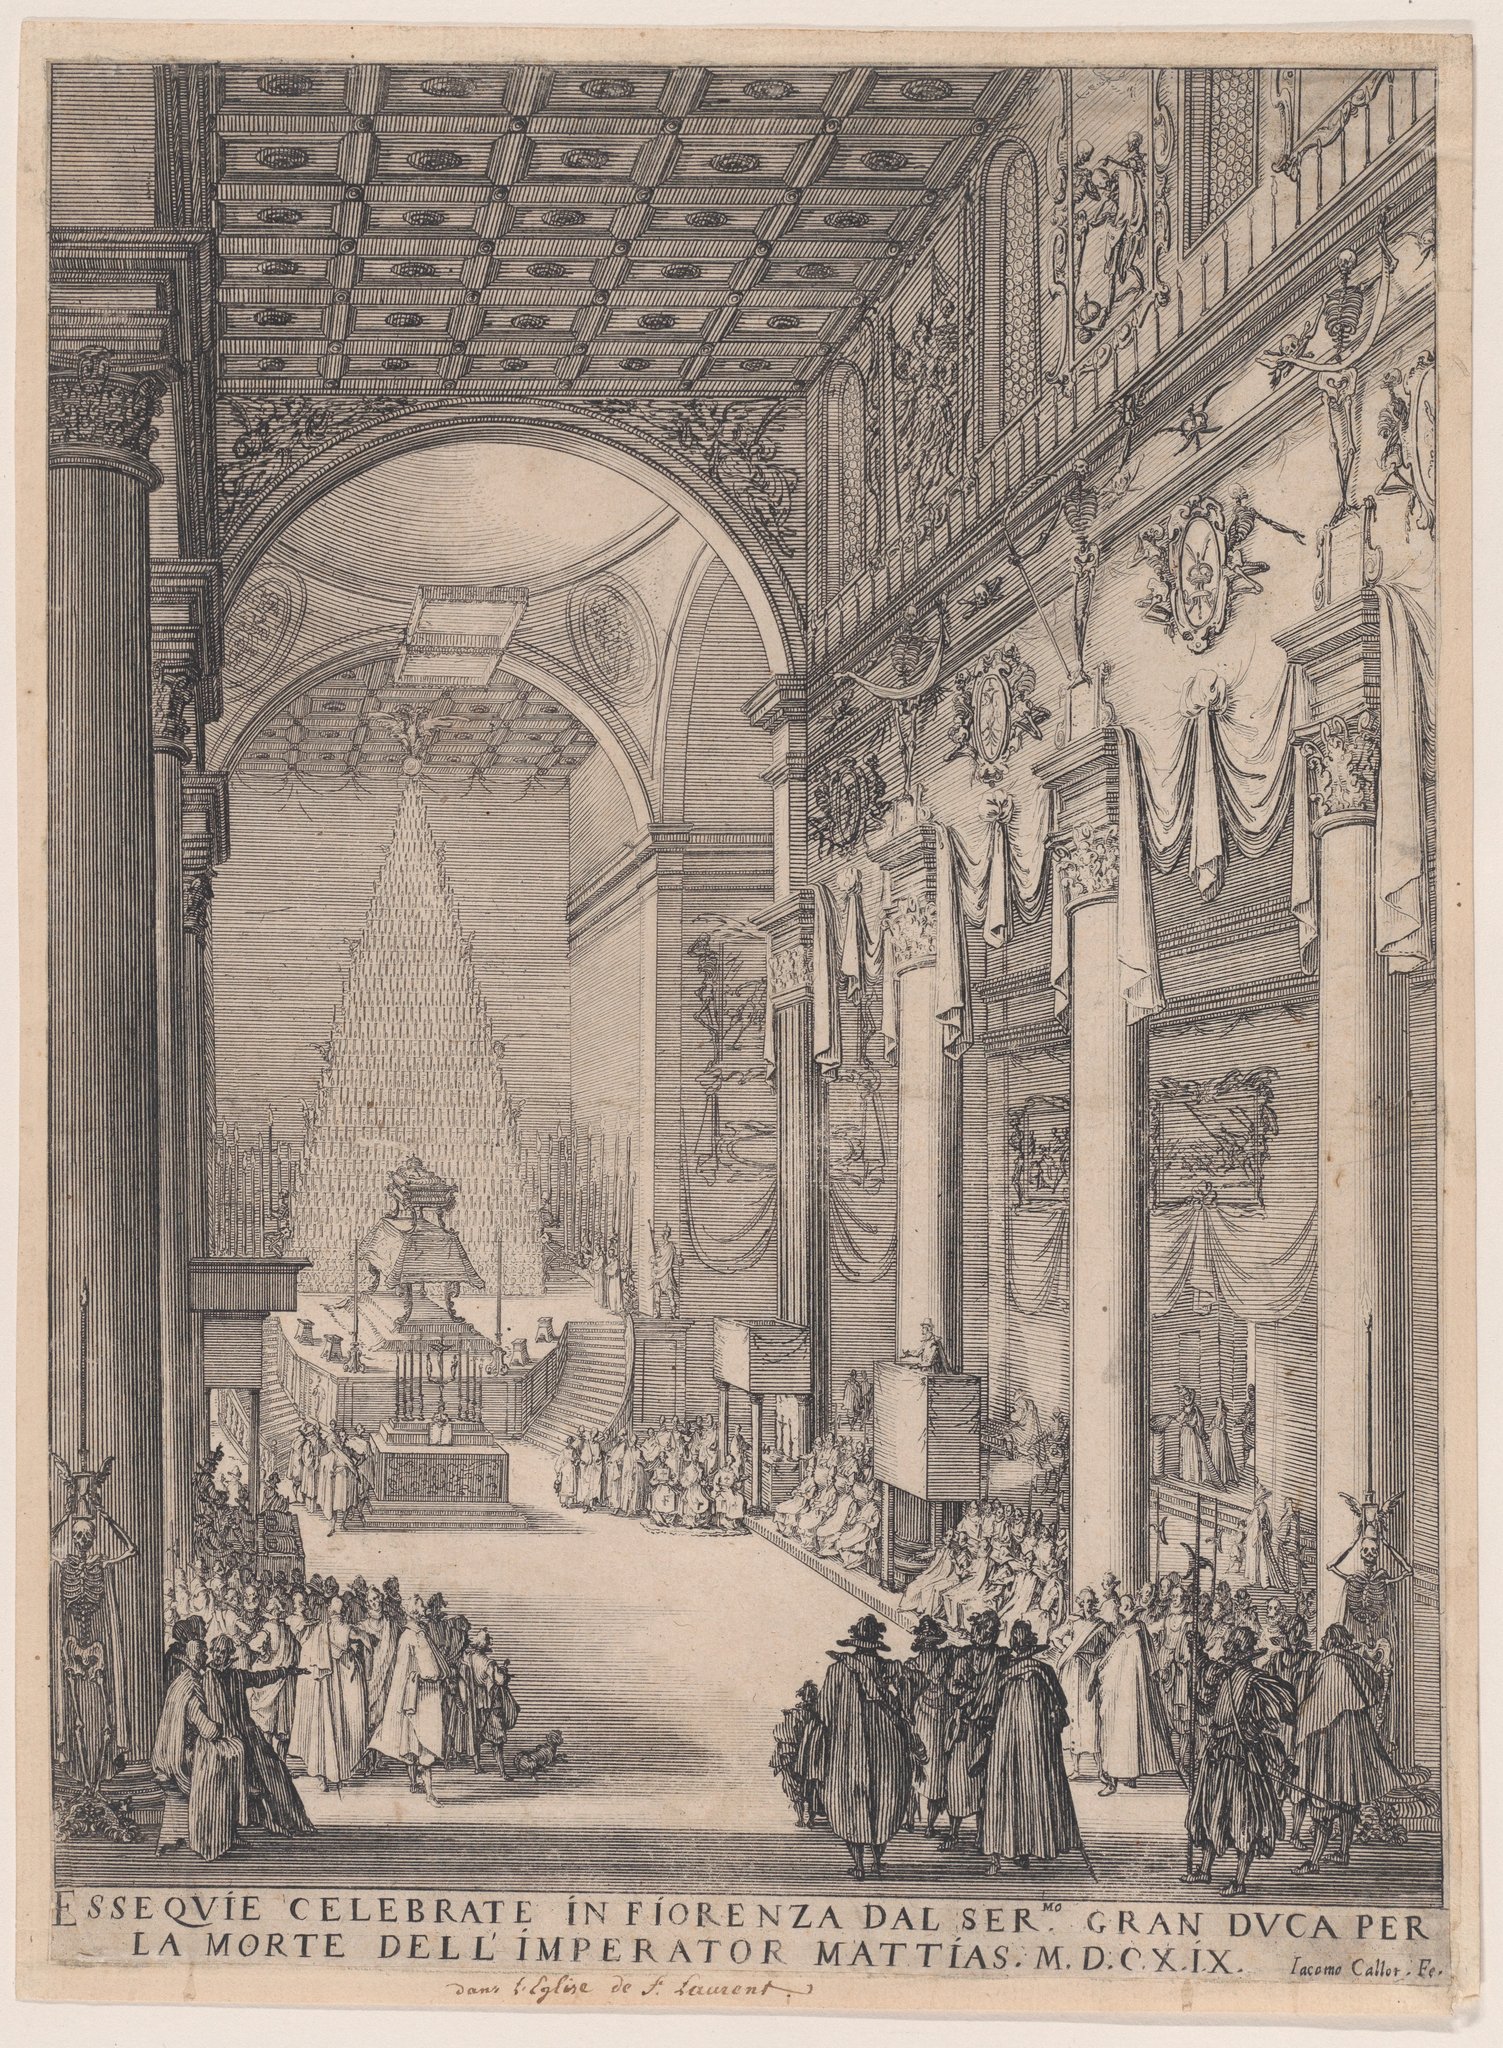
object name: print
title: Le Catafalque de l'Empereur Mathais pièce appelée aussi Le Petit Prédicateur, La Chapelle Funèbre de Florence et Requiem de L'Empereur Mathais (The Catafalque of the Emperor Matthais, piece also called The Small Preacher, The Funerary Chapel of Florence, The Requiem of the Emperor Matthais)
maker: jacques callot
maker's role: artist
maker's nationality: french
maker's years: 1592-1635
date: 1619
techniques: engraving, etching